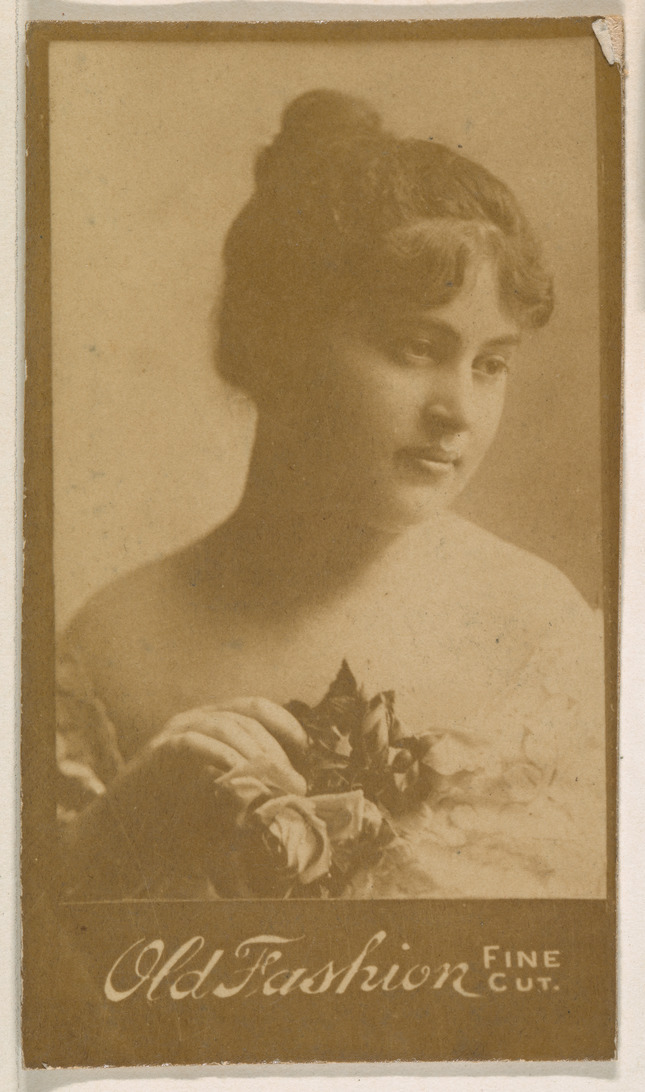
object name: photograph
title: Actress holding rose, from the Actresses series (N664) promoting Old Fashion Fine Cut Tobacco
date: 1888-1890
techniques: albumen silver print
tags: portraits,women,actresses